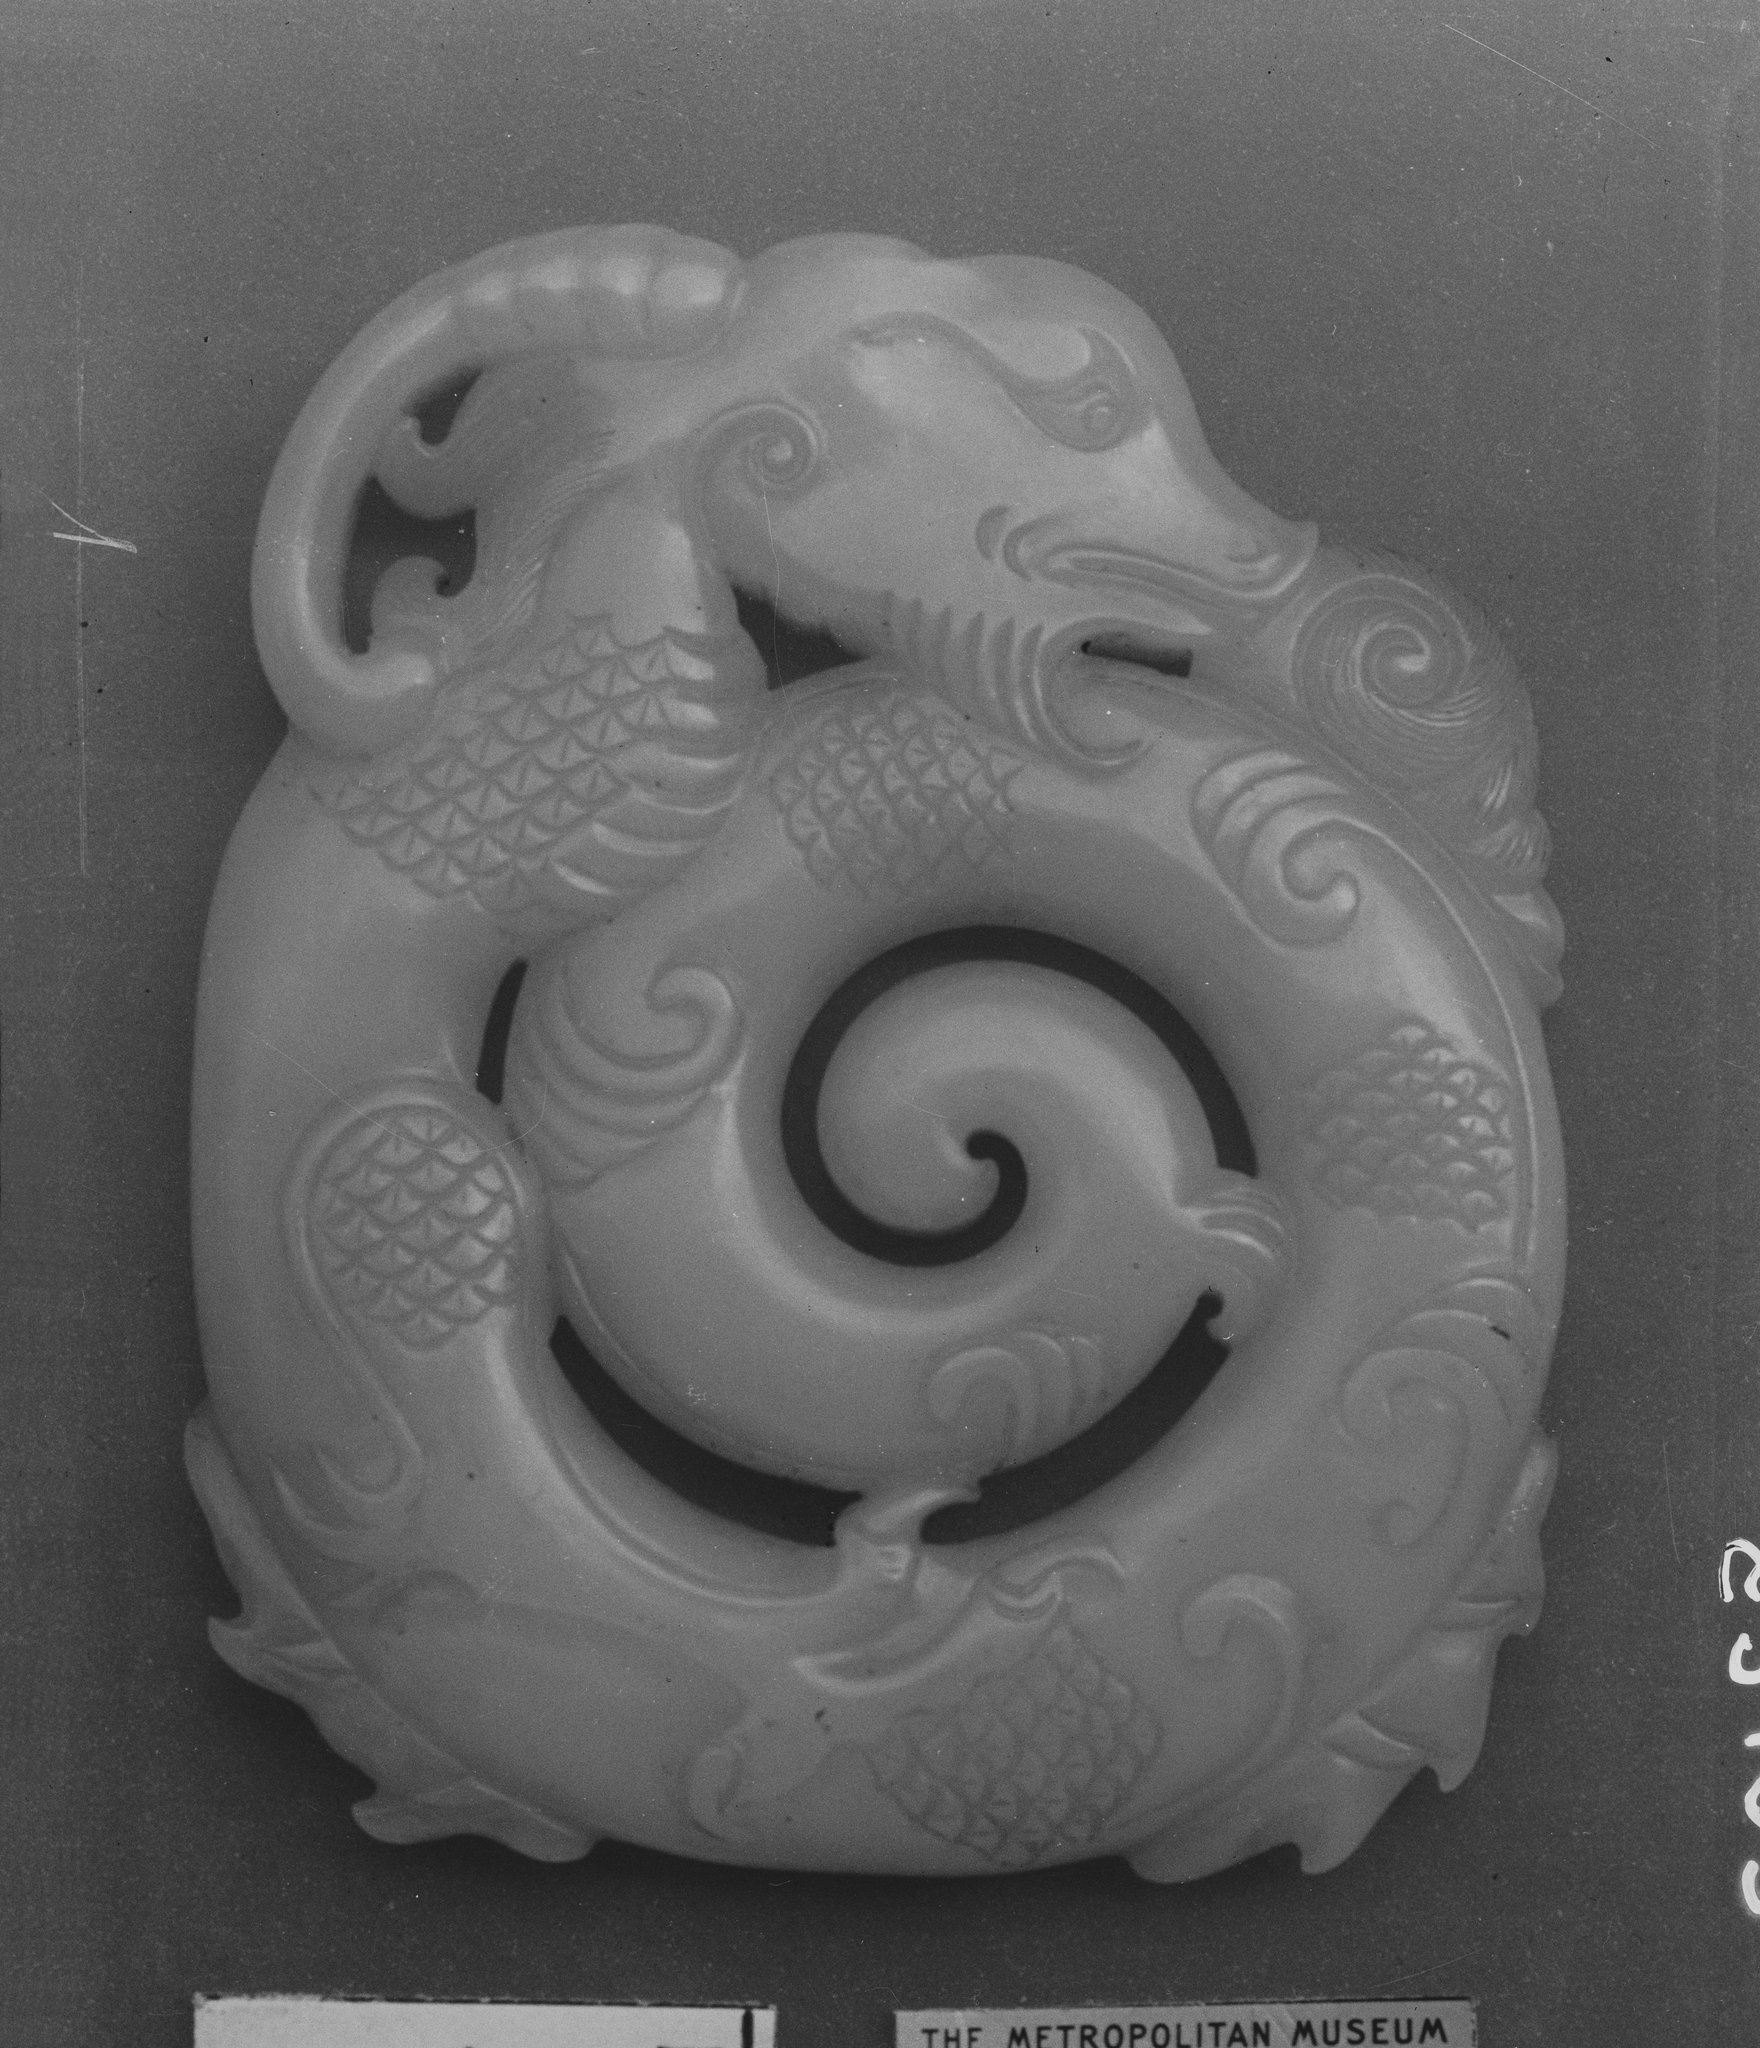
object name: paperweight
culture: chinese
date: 1736-1795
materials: jade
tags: dragons